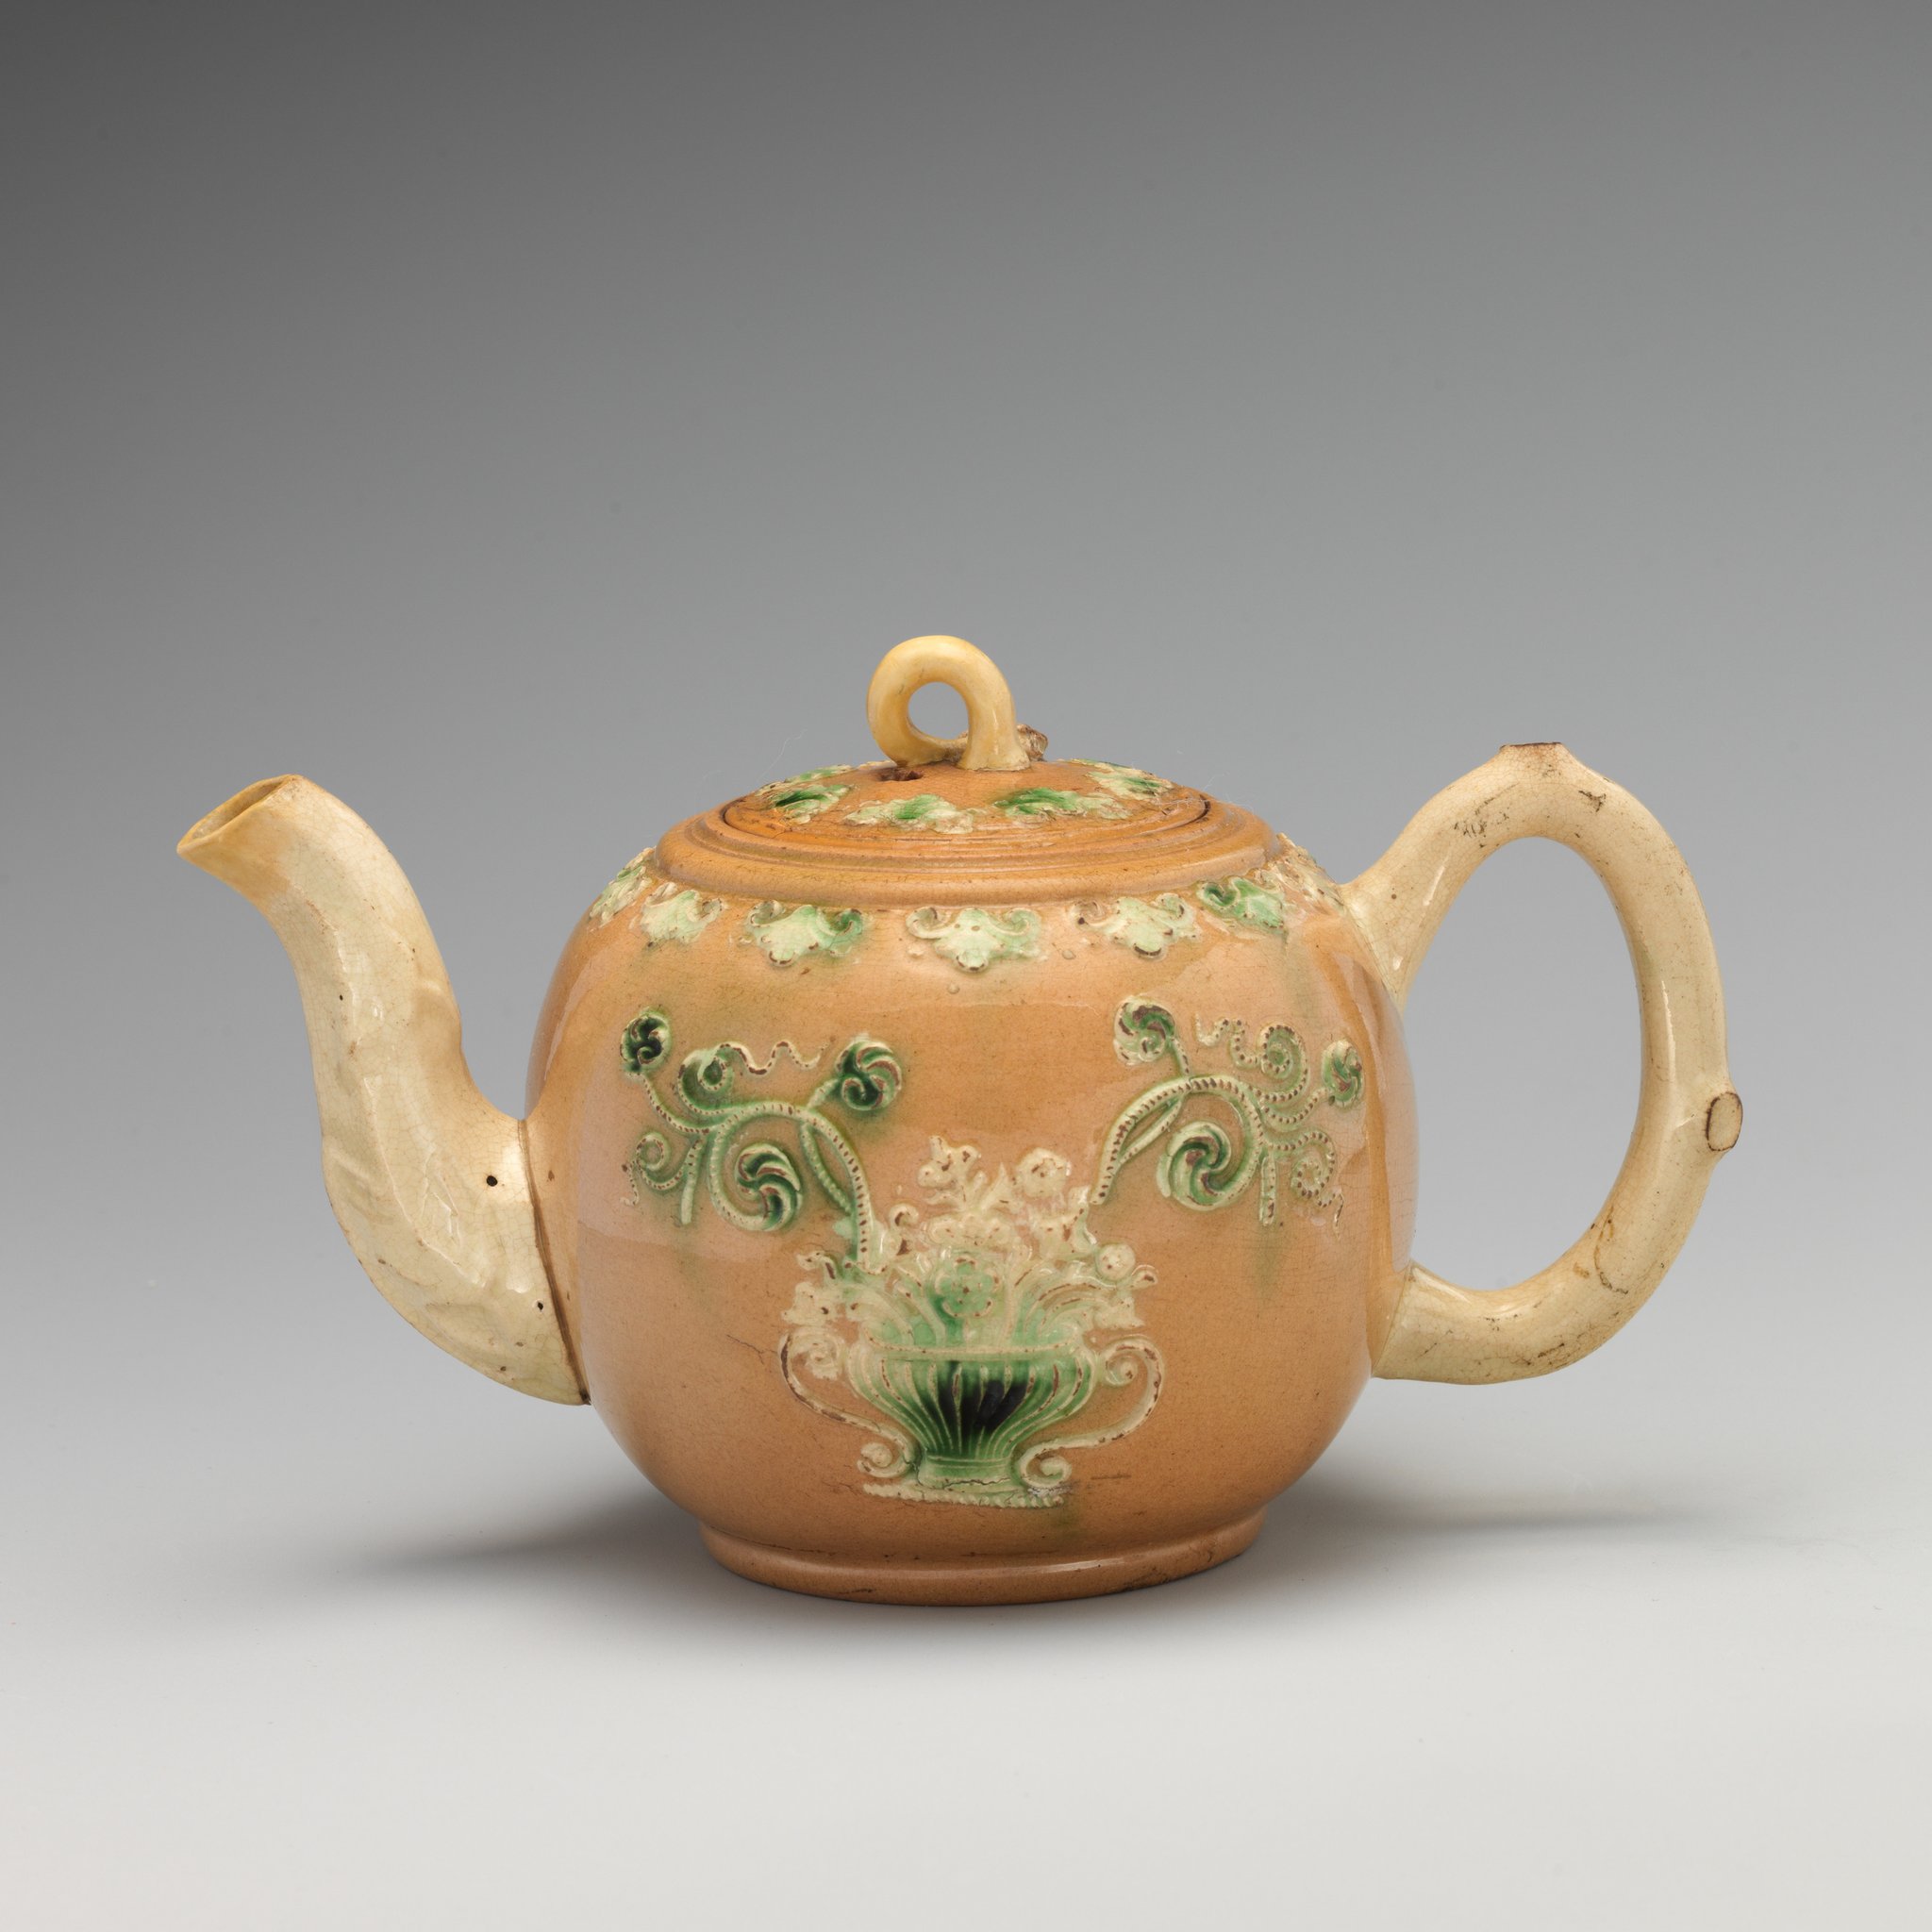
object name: teapot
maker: john astbury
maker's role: maker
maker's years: 1688-1743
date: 1745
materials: earthenware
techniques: glazing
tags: flowers,vines